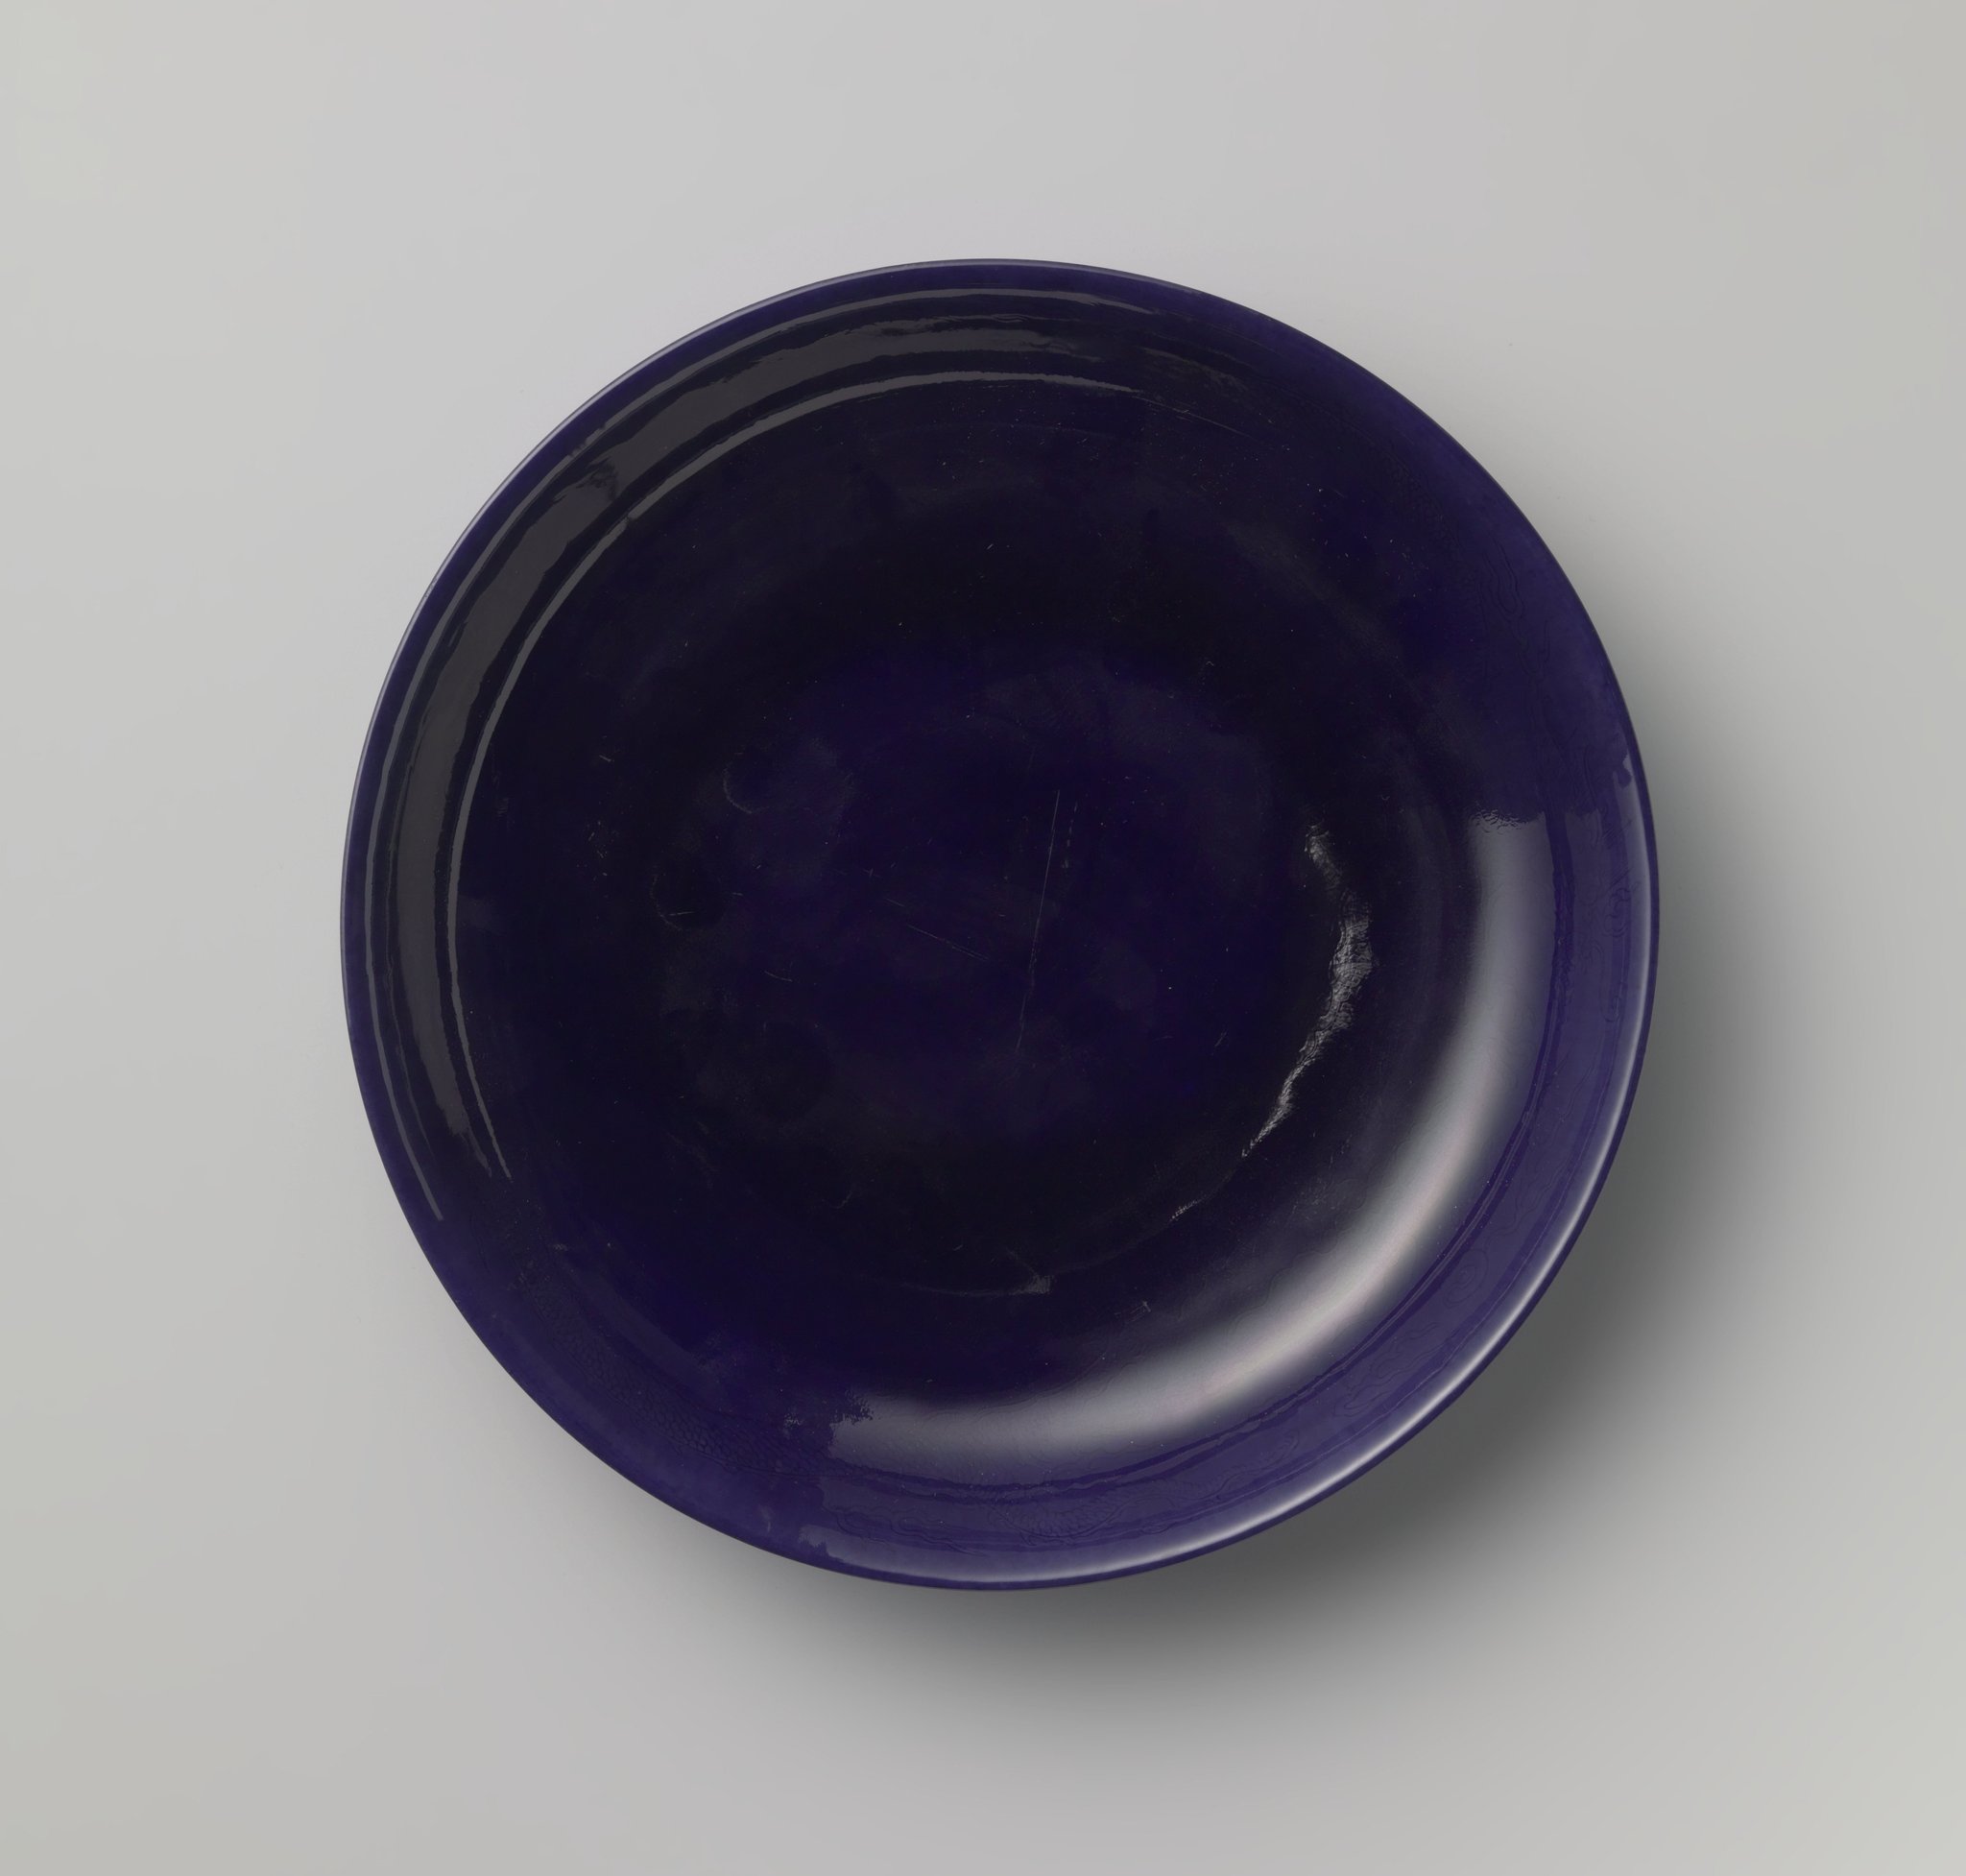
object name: dish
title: Saucer-dish with incised pearl chasing dragons between clouds and flames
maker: Anonymous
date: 1680-1720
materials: glaze, porcelain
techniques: engraving, firing, turning, vitrification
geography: china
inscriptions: mark: ‘大 清 康 熙 年 製’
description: Aubergine is one of the monochrome glazes of the Qing Dynasty (1644-1911). With its purplish tonality it differs from the dark blue or turquoise-blue glazes of the Ming Dynasty (1368-1644). The glaze is slightly thinner around the rim of these dishes, and appears as a dark purple on the more thickly coated well.